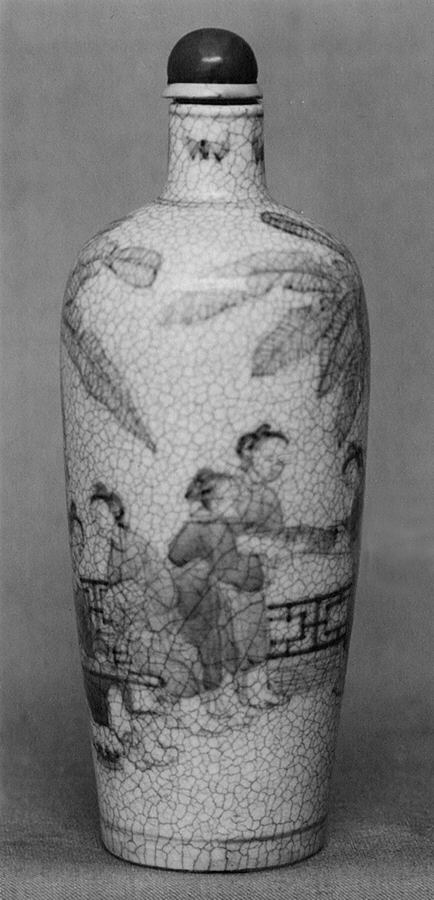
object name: snuff bottle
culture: chinese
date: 1723-1735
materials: soft paste porcelain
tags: human figures